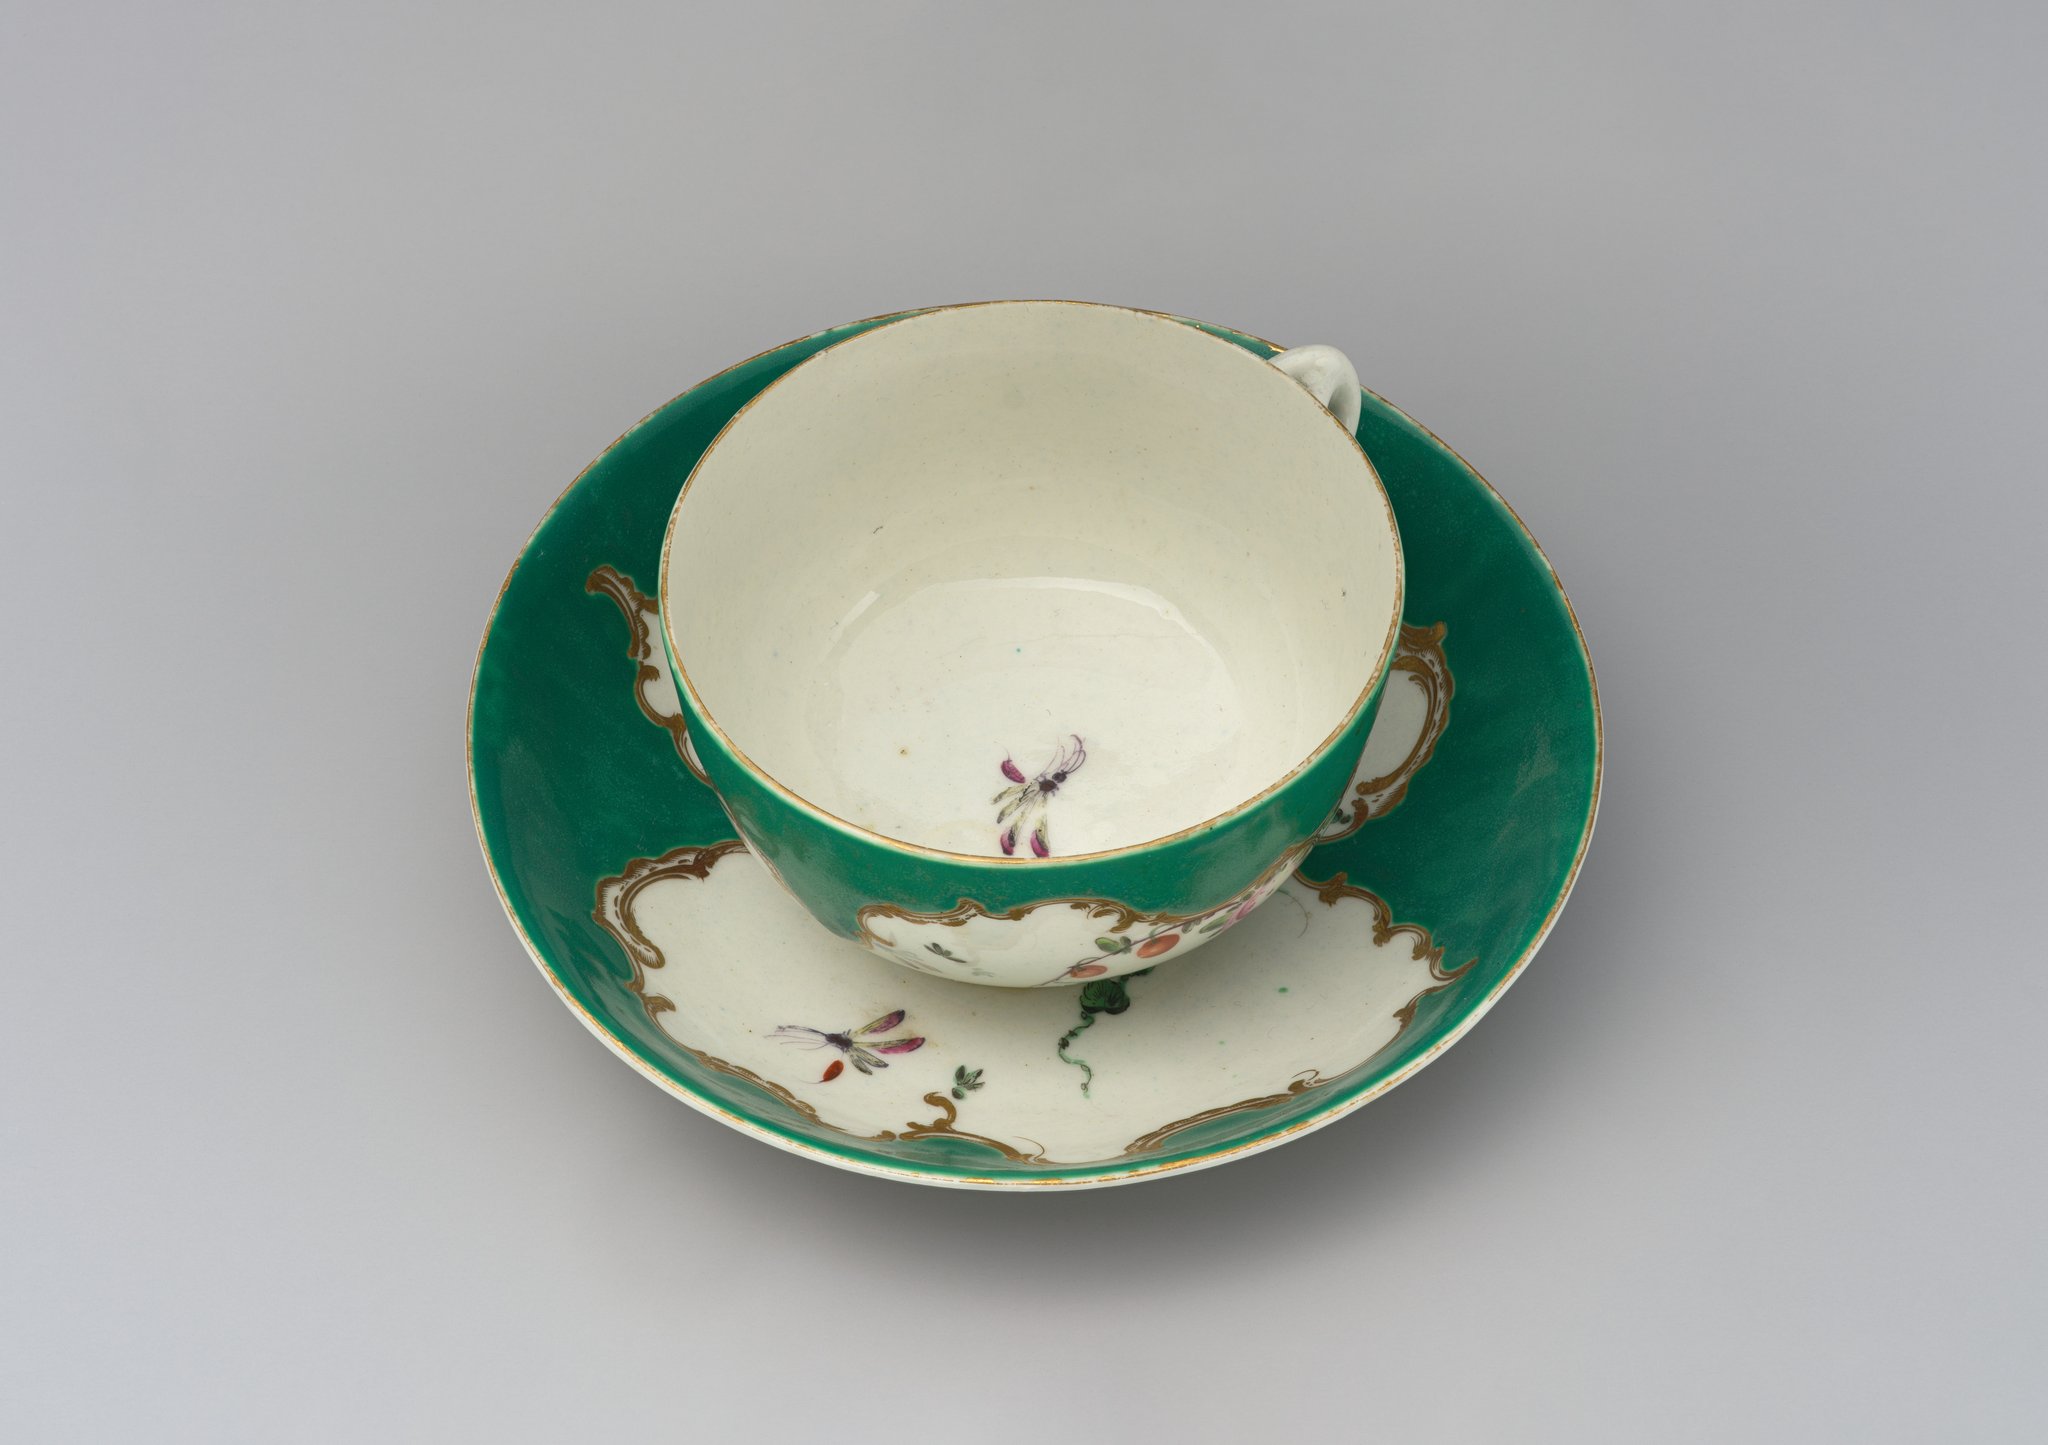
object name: saucer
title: Saucer (part of a service)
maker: worcester factory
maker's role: factory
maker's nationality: british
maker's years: 1751-2008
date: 1770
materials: soft paste porcelain